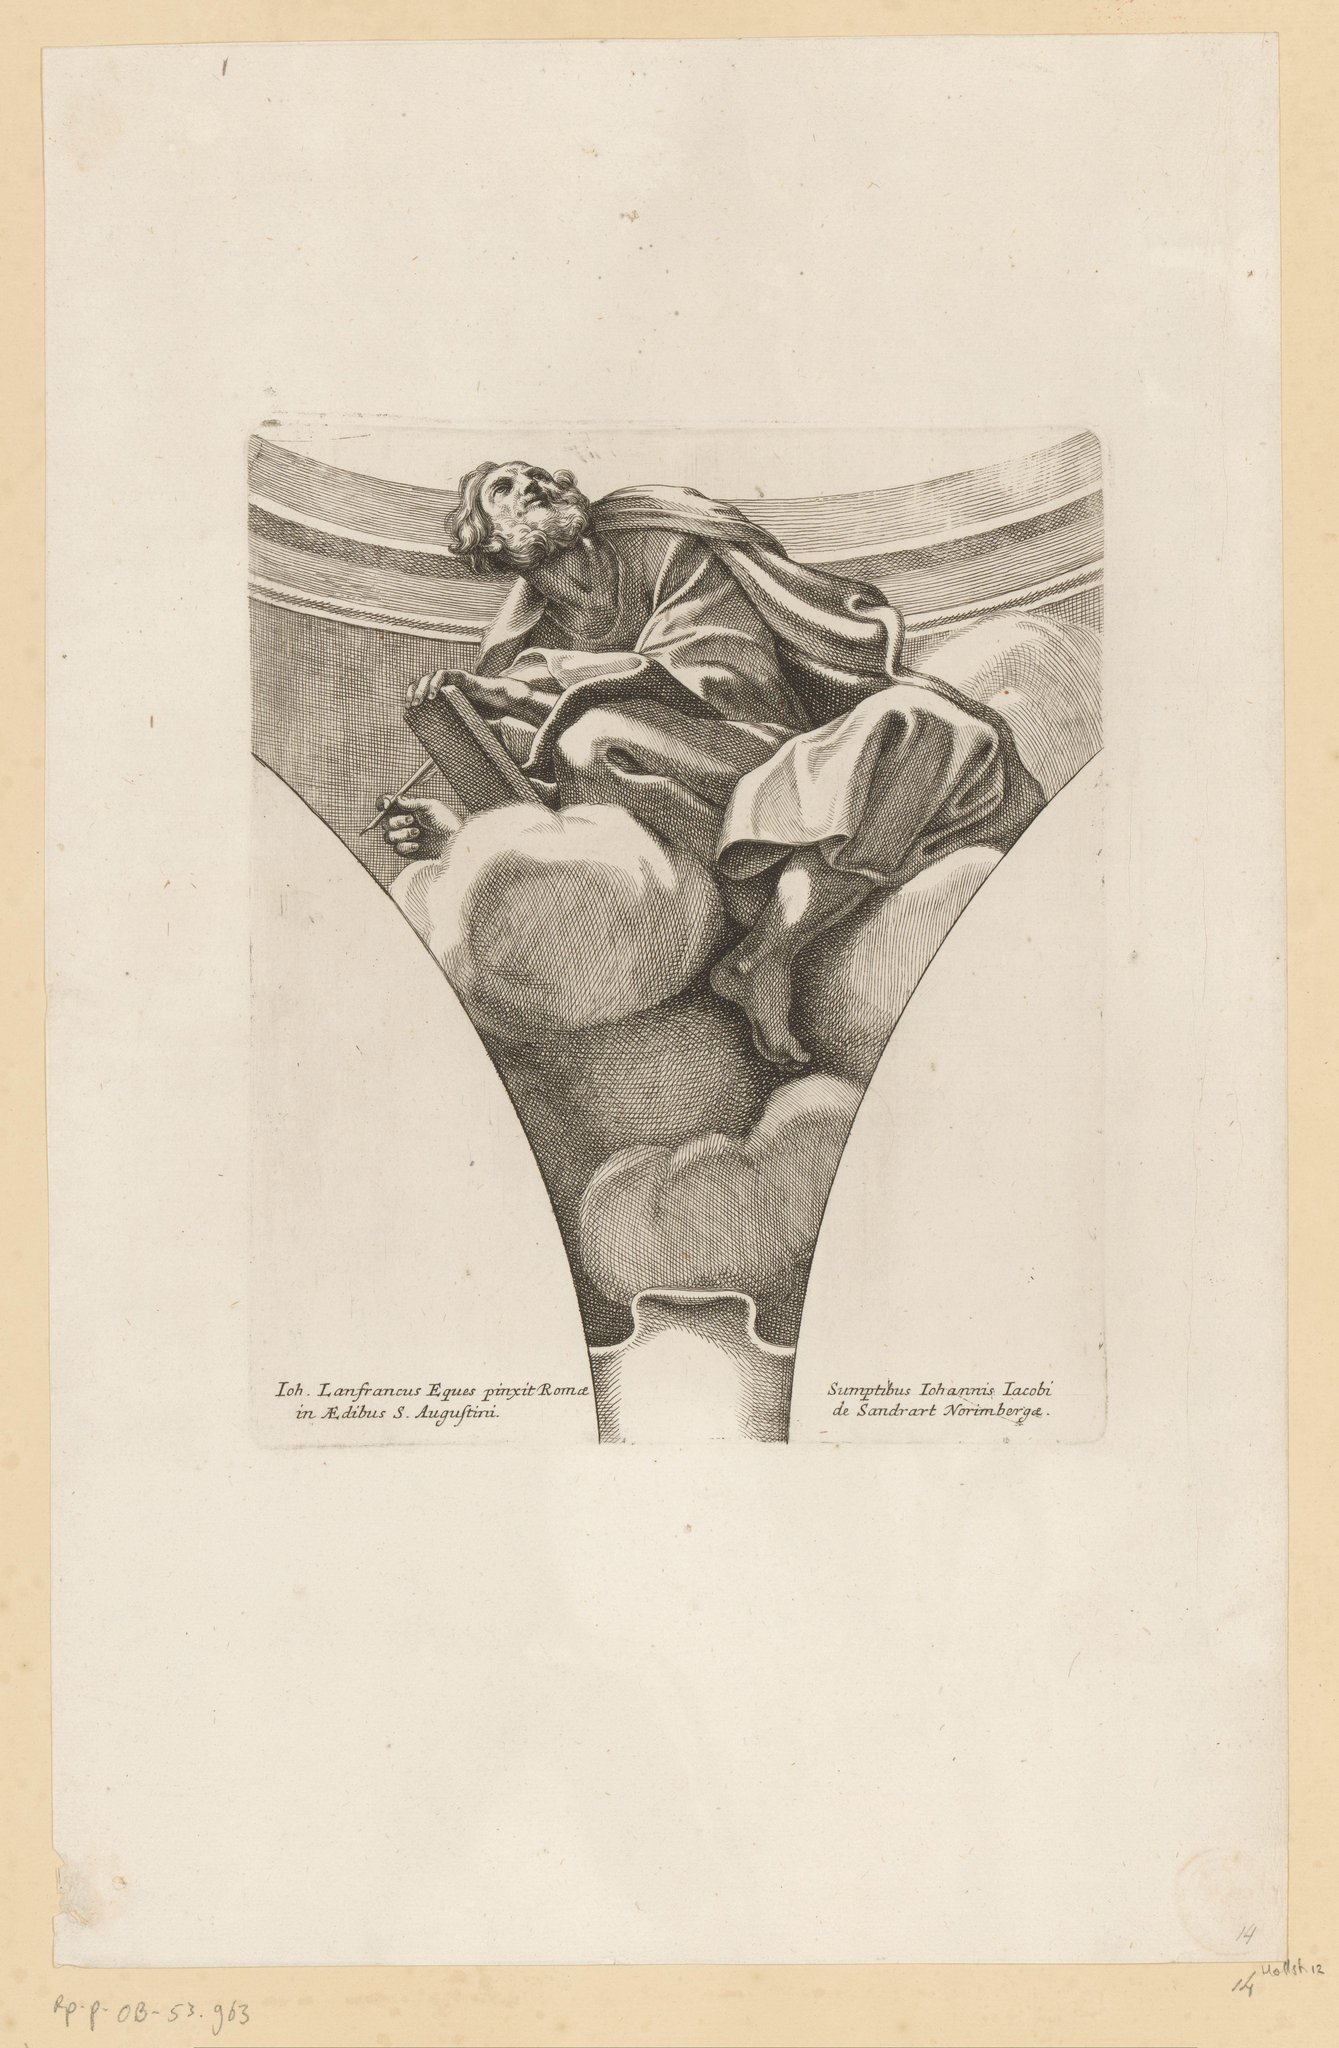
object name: print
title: Schilderijen in de Sant'Agostino in Rome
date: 1665-1698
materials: paper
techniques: etching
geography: rome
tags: the four evangelists without their symbols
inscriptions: collector's mark: Lugt 240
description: Onderdeel van een serie van negen prenten naar schilderijen in de Sant'Agostino in Rome.